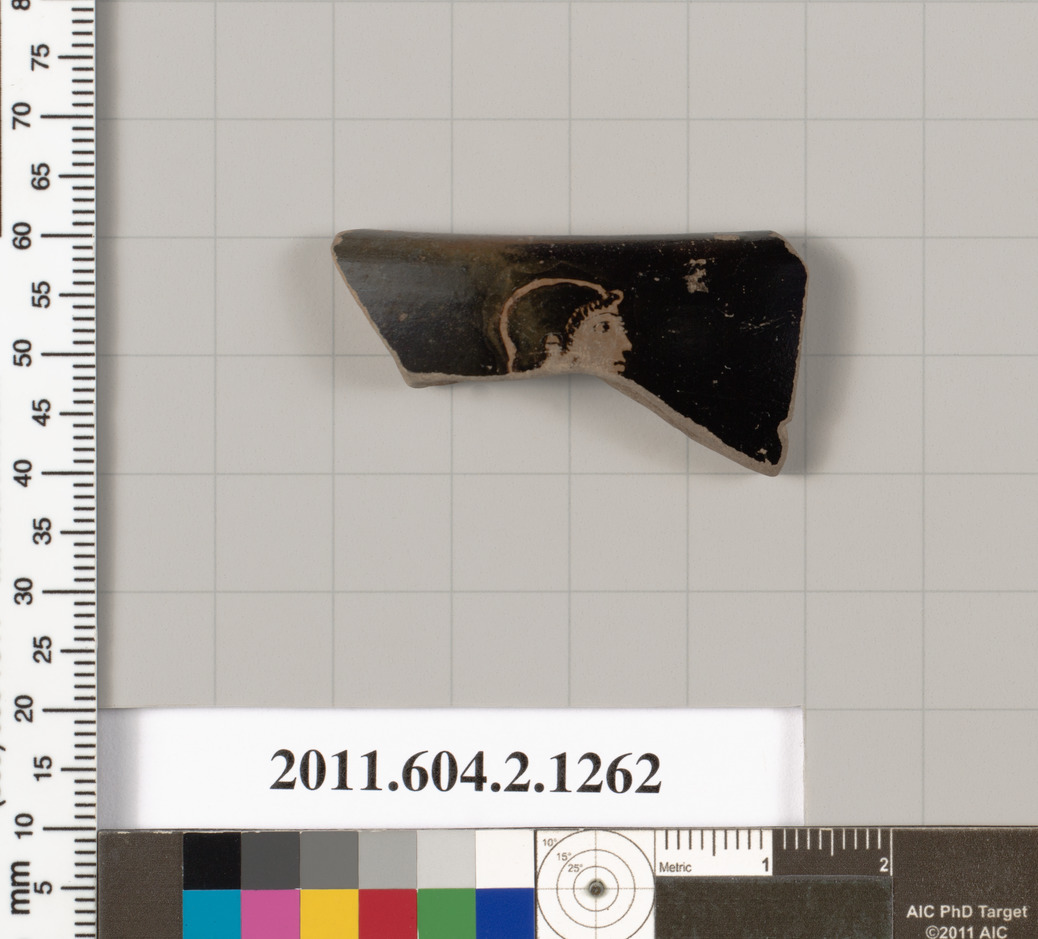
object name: skyphos fragment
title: Terracotta rim fragment of a skyphos (deep drinking cup)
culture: greek, attic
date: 475-451 BCE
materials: terracotta